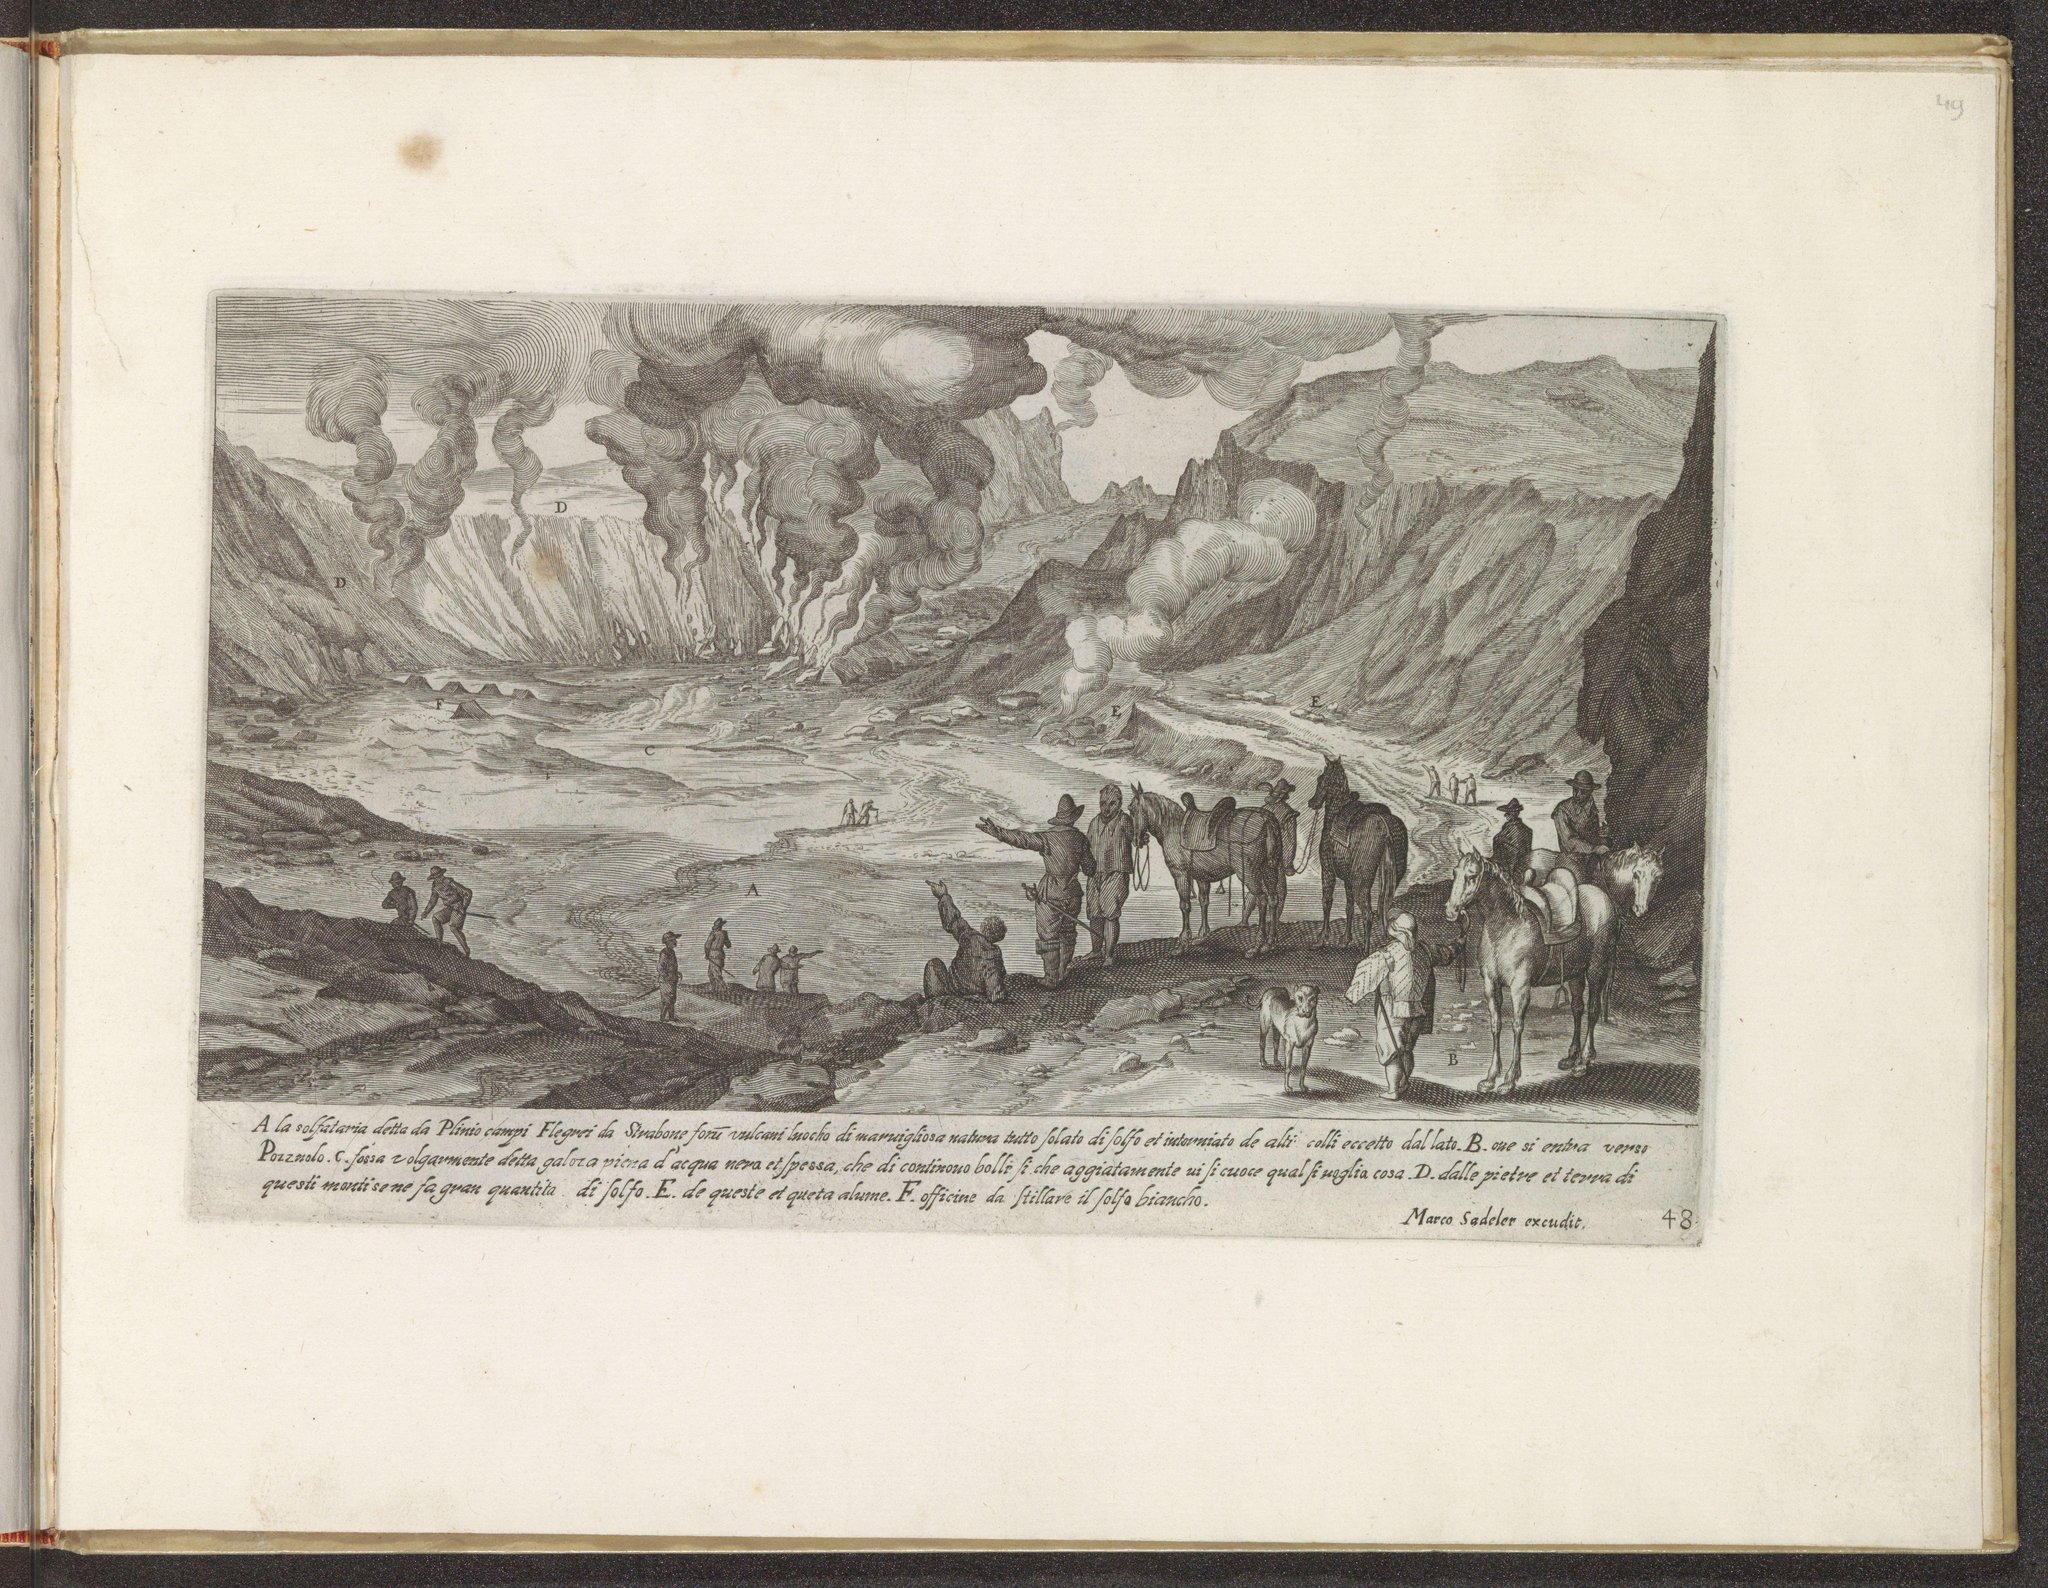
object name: print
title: Vestigi della antichita di Roma, Tivoli, Pozzuolo et altri Luochi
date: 1606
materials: paper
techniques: engraving, etching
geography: prague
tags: solfatara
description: De Campi Flegrei (Brandende velden) of Flegreïsche Velden, ten noorden van Napels. De Solfatara vulkaan of Forum Vulcani is hier onderdeel van. Op de voorgrond mannen en paarden. In de ondermarge drie regels tekst in het Italiaans. De prent maakt deel uit van een album.